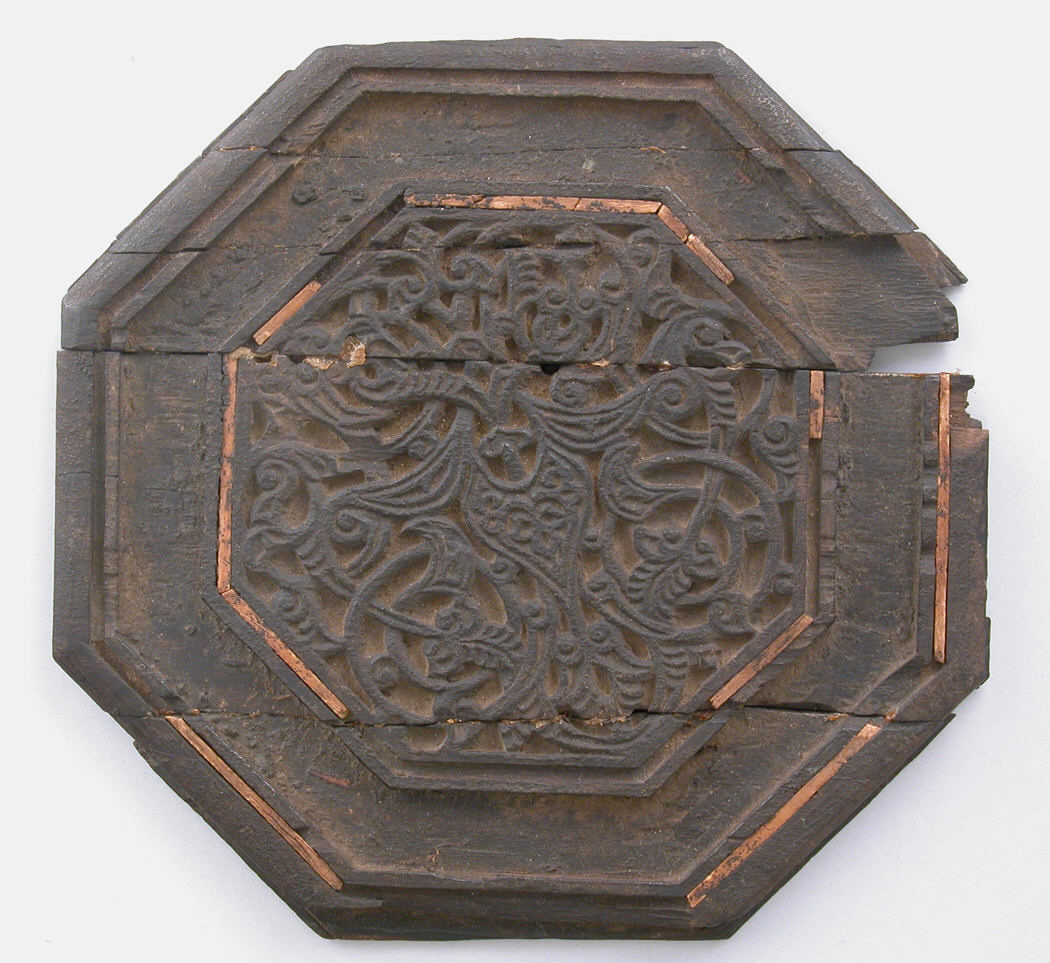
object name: panel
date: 1201-1400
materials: ivory, wood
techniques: carving, inlay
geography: egypt